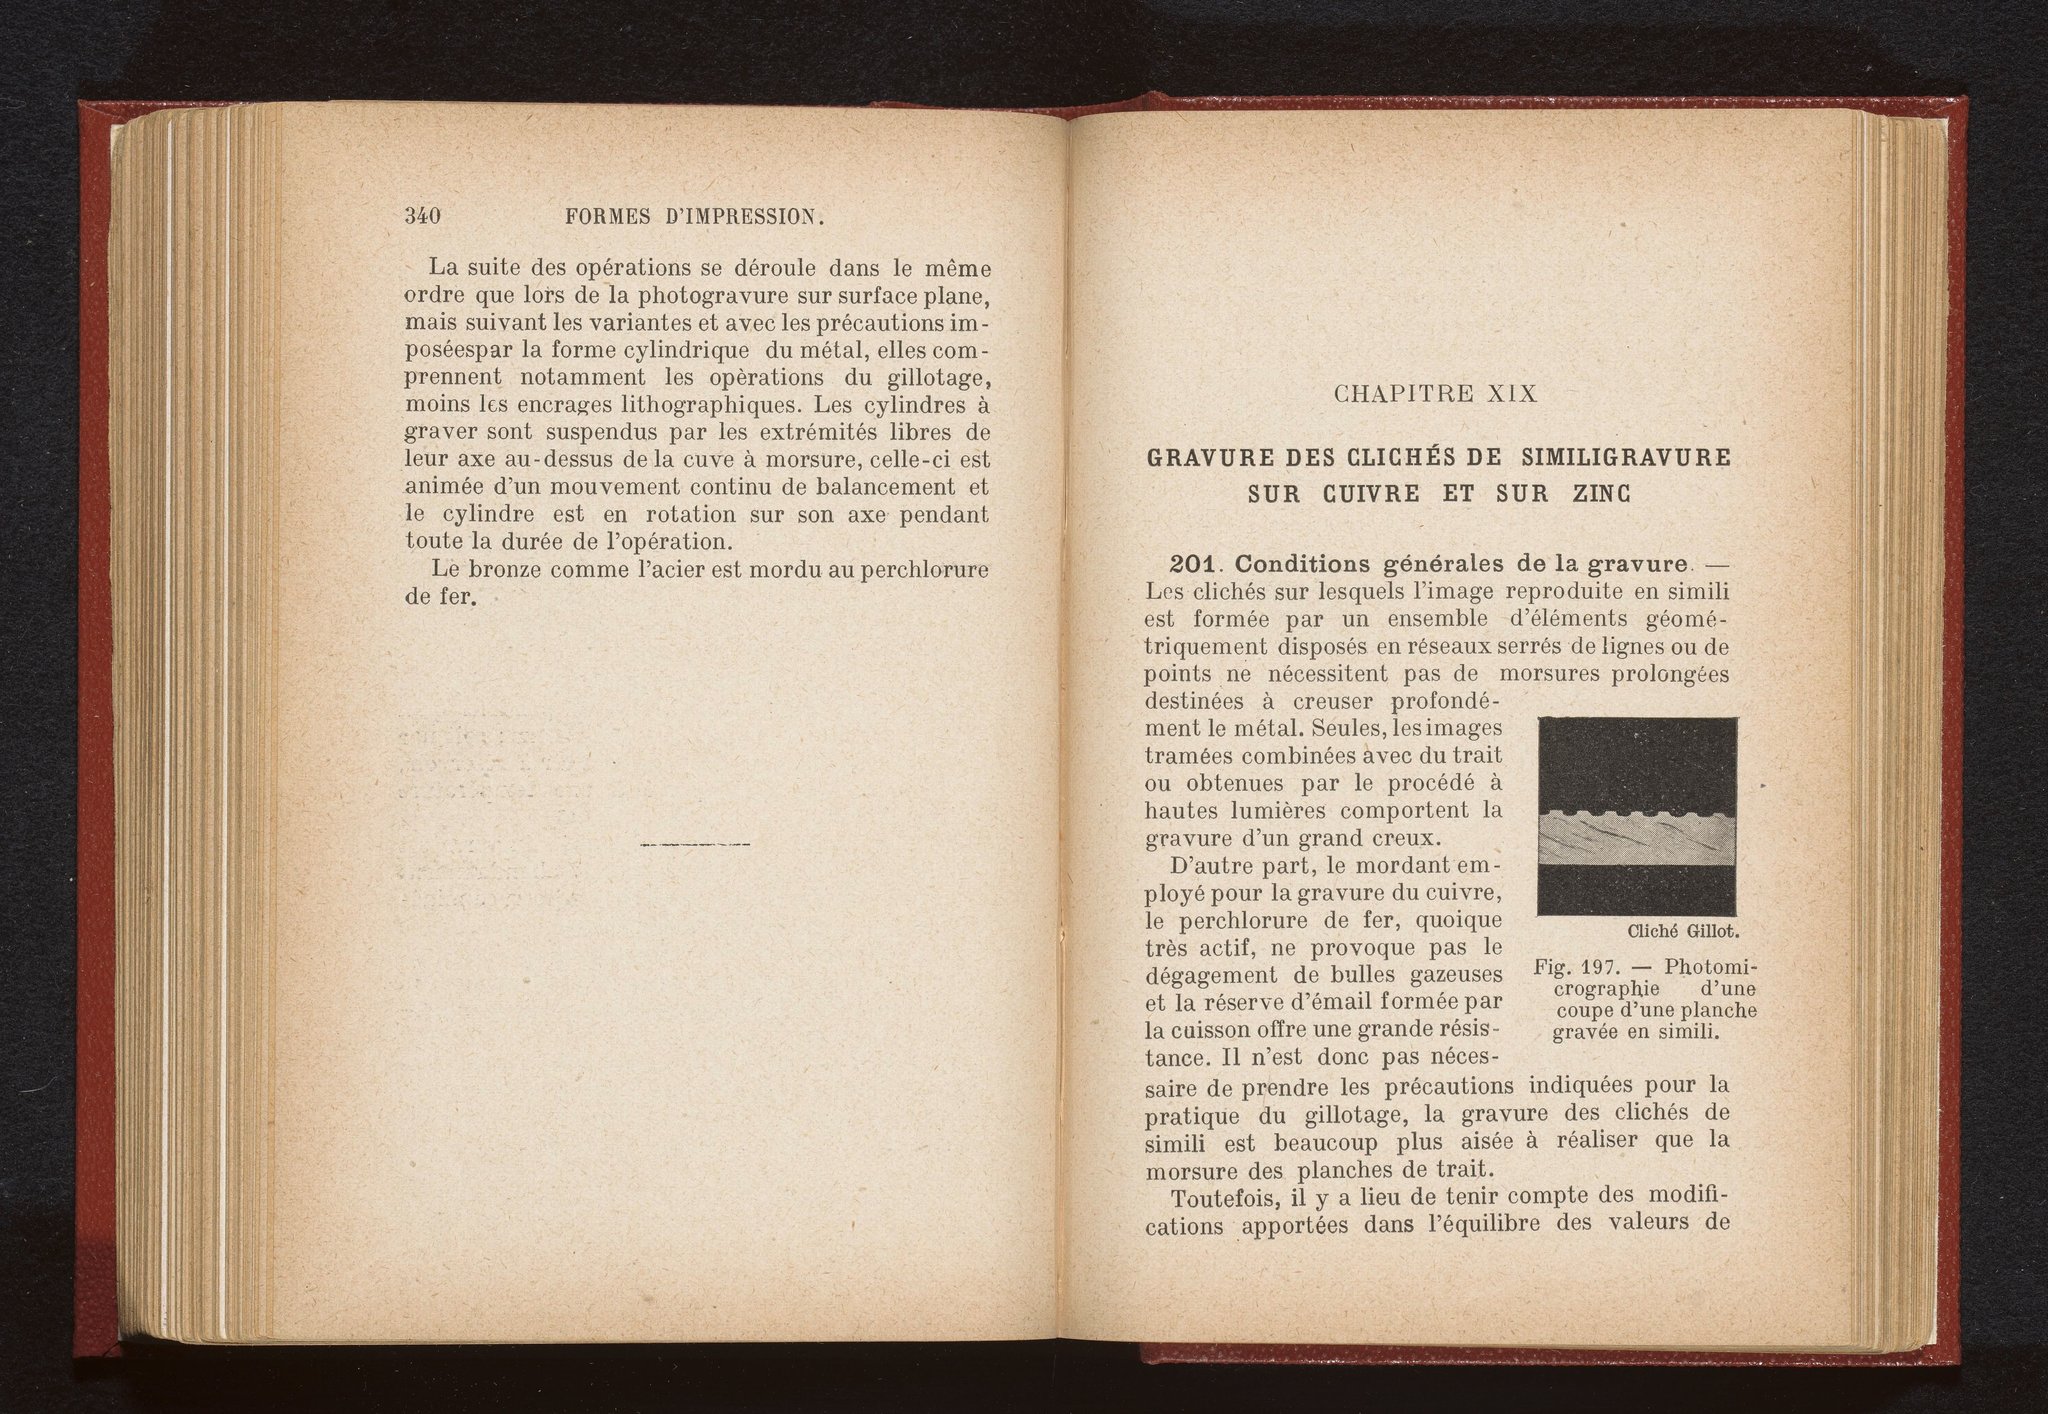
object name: photomechanical print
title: Photomicrographie d'une coupe d'une planche gravée en simili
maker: Anonymous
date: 1922-1932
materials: paper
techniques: autotype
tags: print, e.g.: engraving, etching, lithograph, photographic apparatus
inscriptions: number: ‘Fig. 197.’